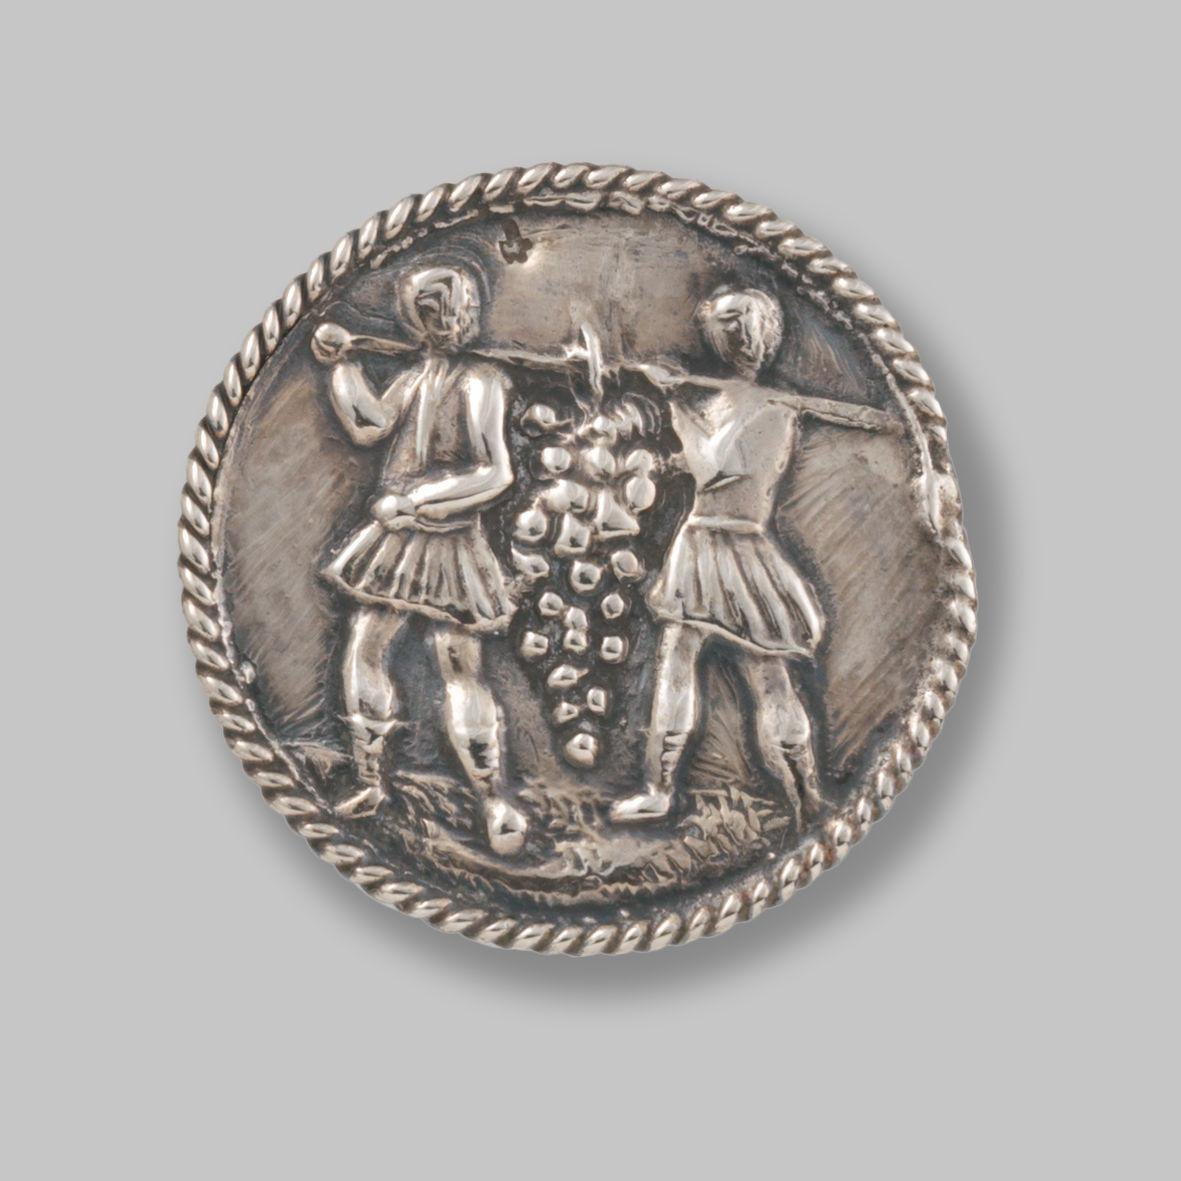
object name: button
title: Knoop met voorstelling van Jozef en Caleb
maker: Anonymous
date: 1850-1900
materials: silver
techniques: casting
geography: netherlands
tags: the grapes of canaan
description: Knoop van gegoten zilver, rond, met op de voorzijde Jozef en Caleb. Aan de achterzijde is een uit gebogen draad vervaardigd oog bevestigd.